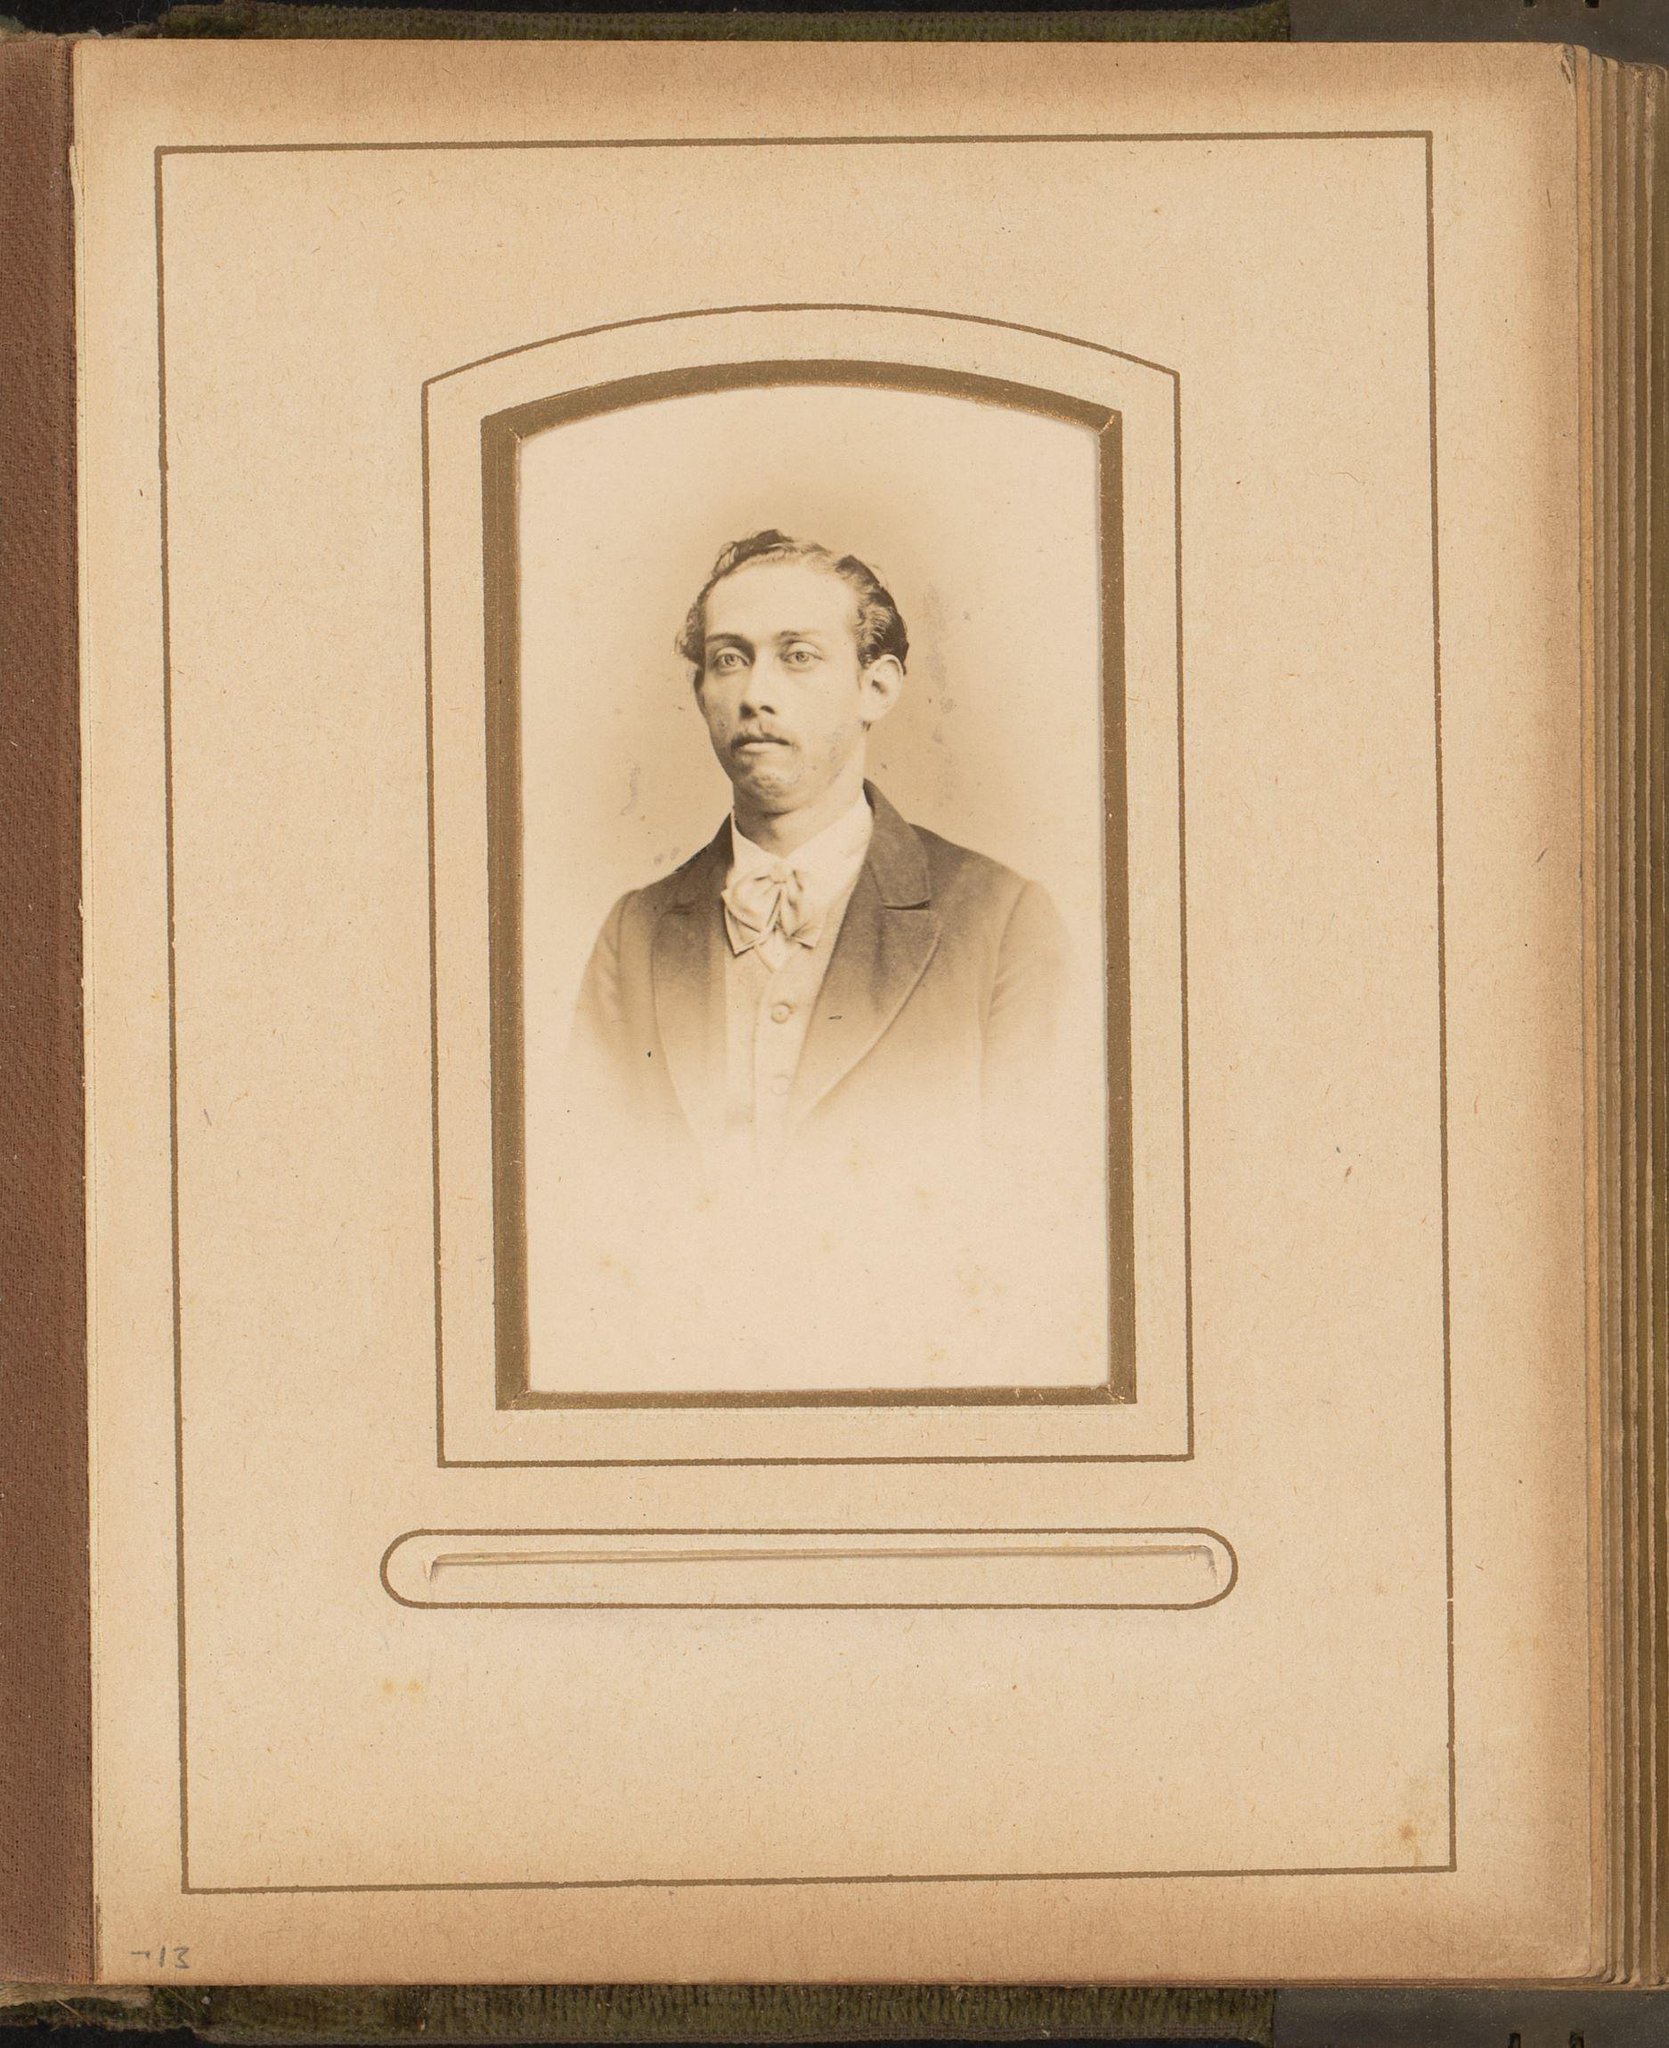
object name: photograph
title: Portret van een man, mogelijk lid van de familie Beucker Andreae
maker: Anonymous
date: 1854-1885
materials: cardboard, paper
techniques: albumen print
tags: adult man, anonymous historical person portrayed